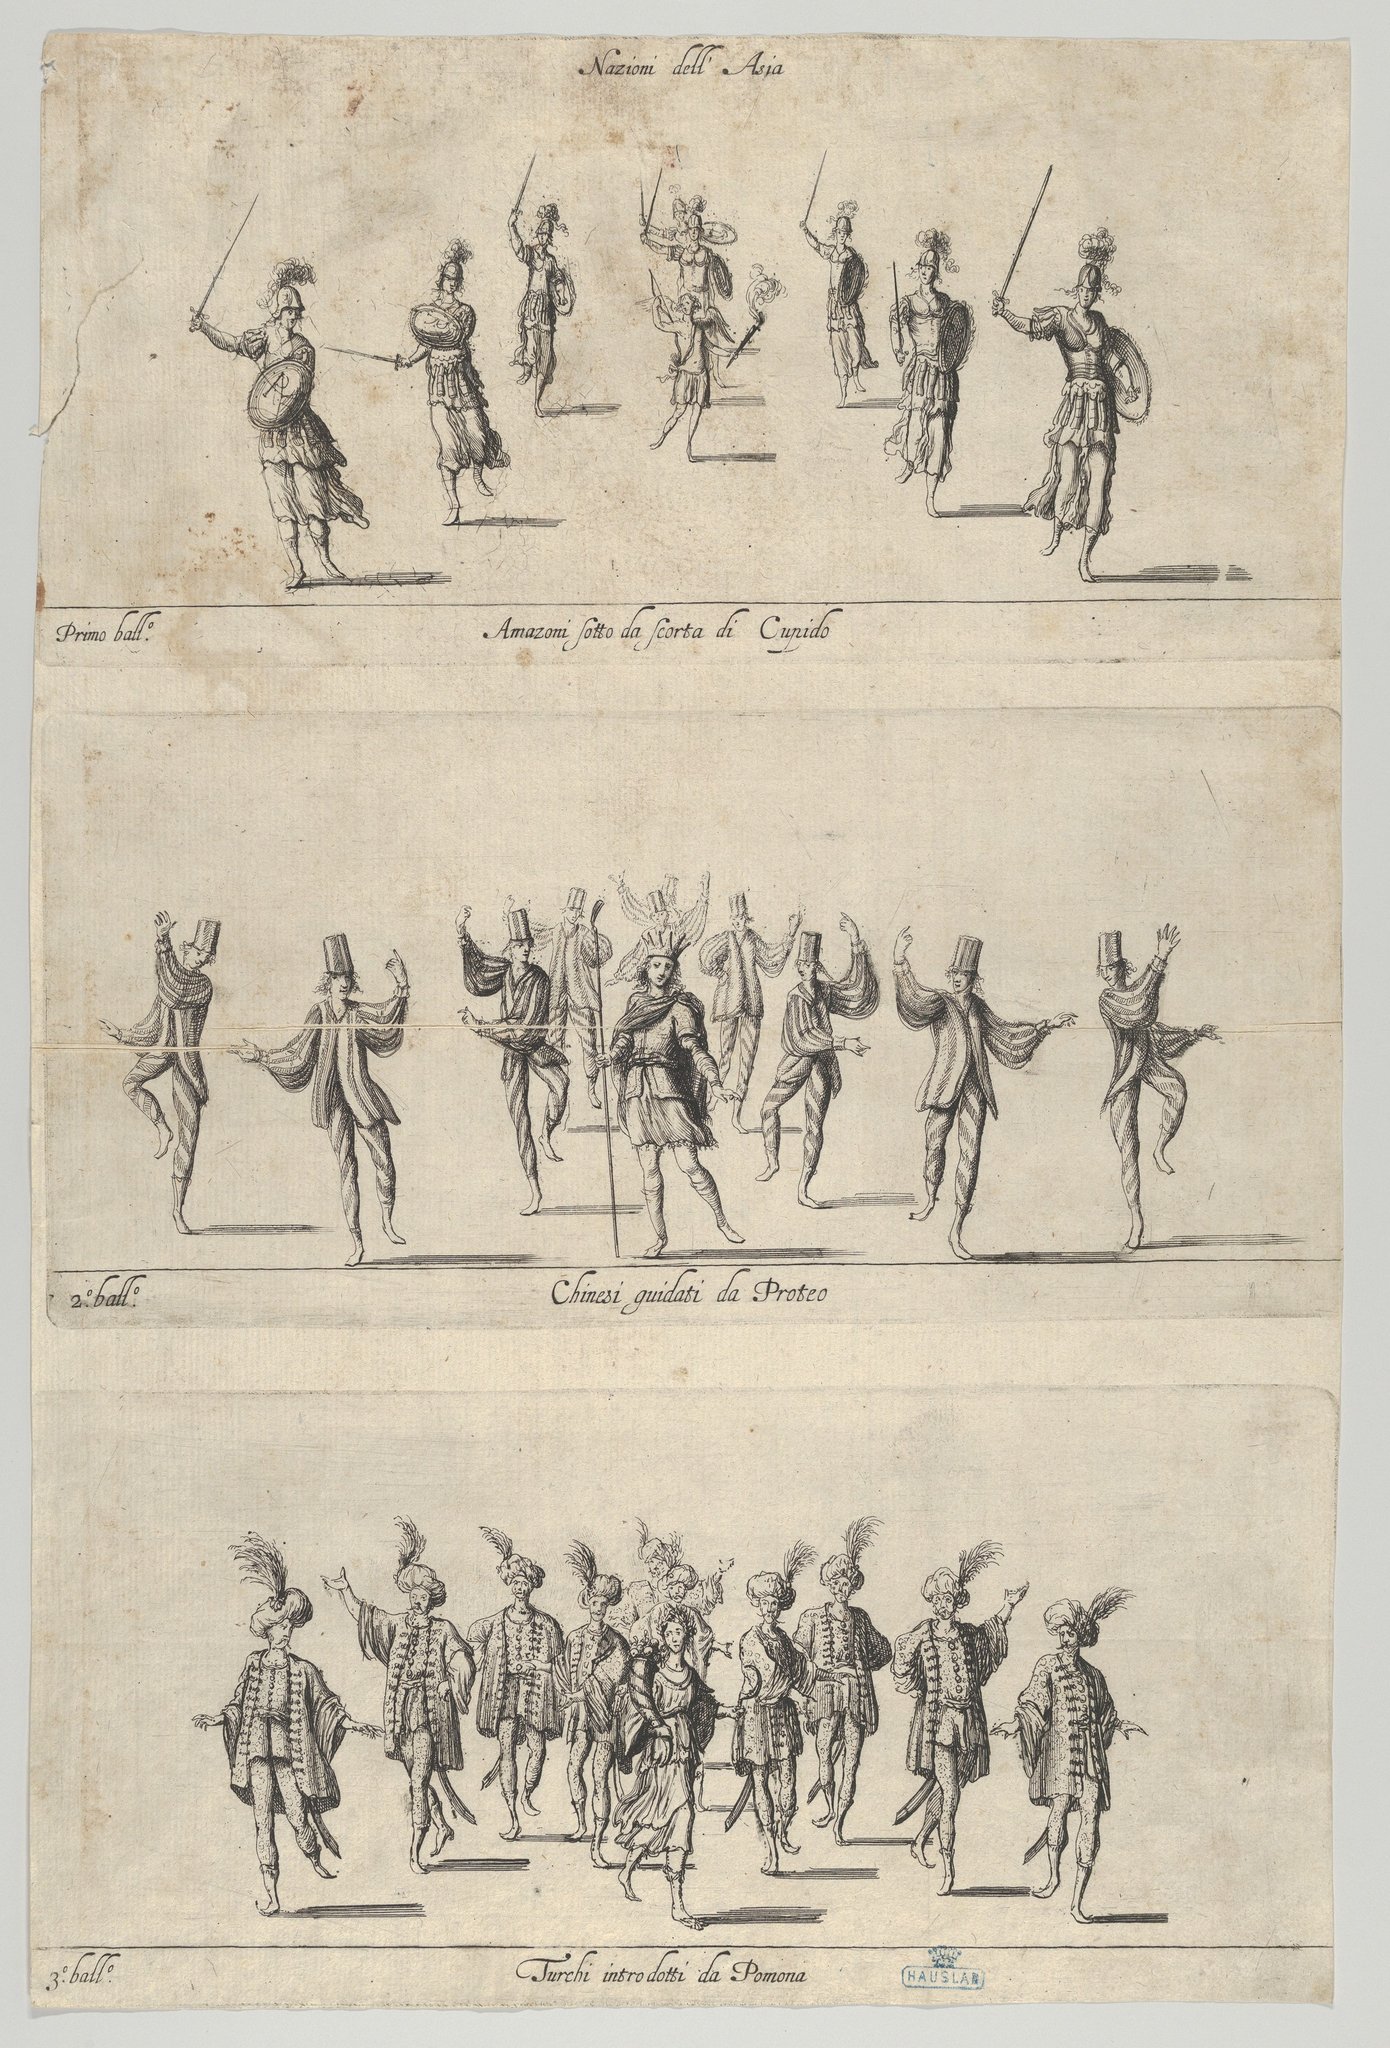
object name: print, fete, ornament architecture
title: Nations of Asia ballets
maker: anonymous, italian, 17th century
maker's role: artist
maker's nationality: italian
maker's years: 1600-1700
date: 1601-1700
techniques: etching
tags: men,dancing